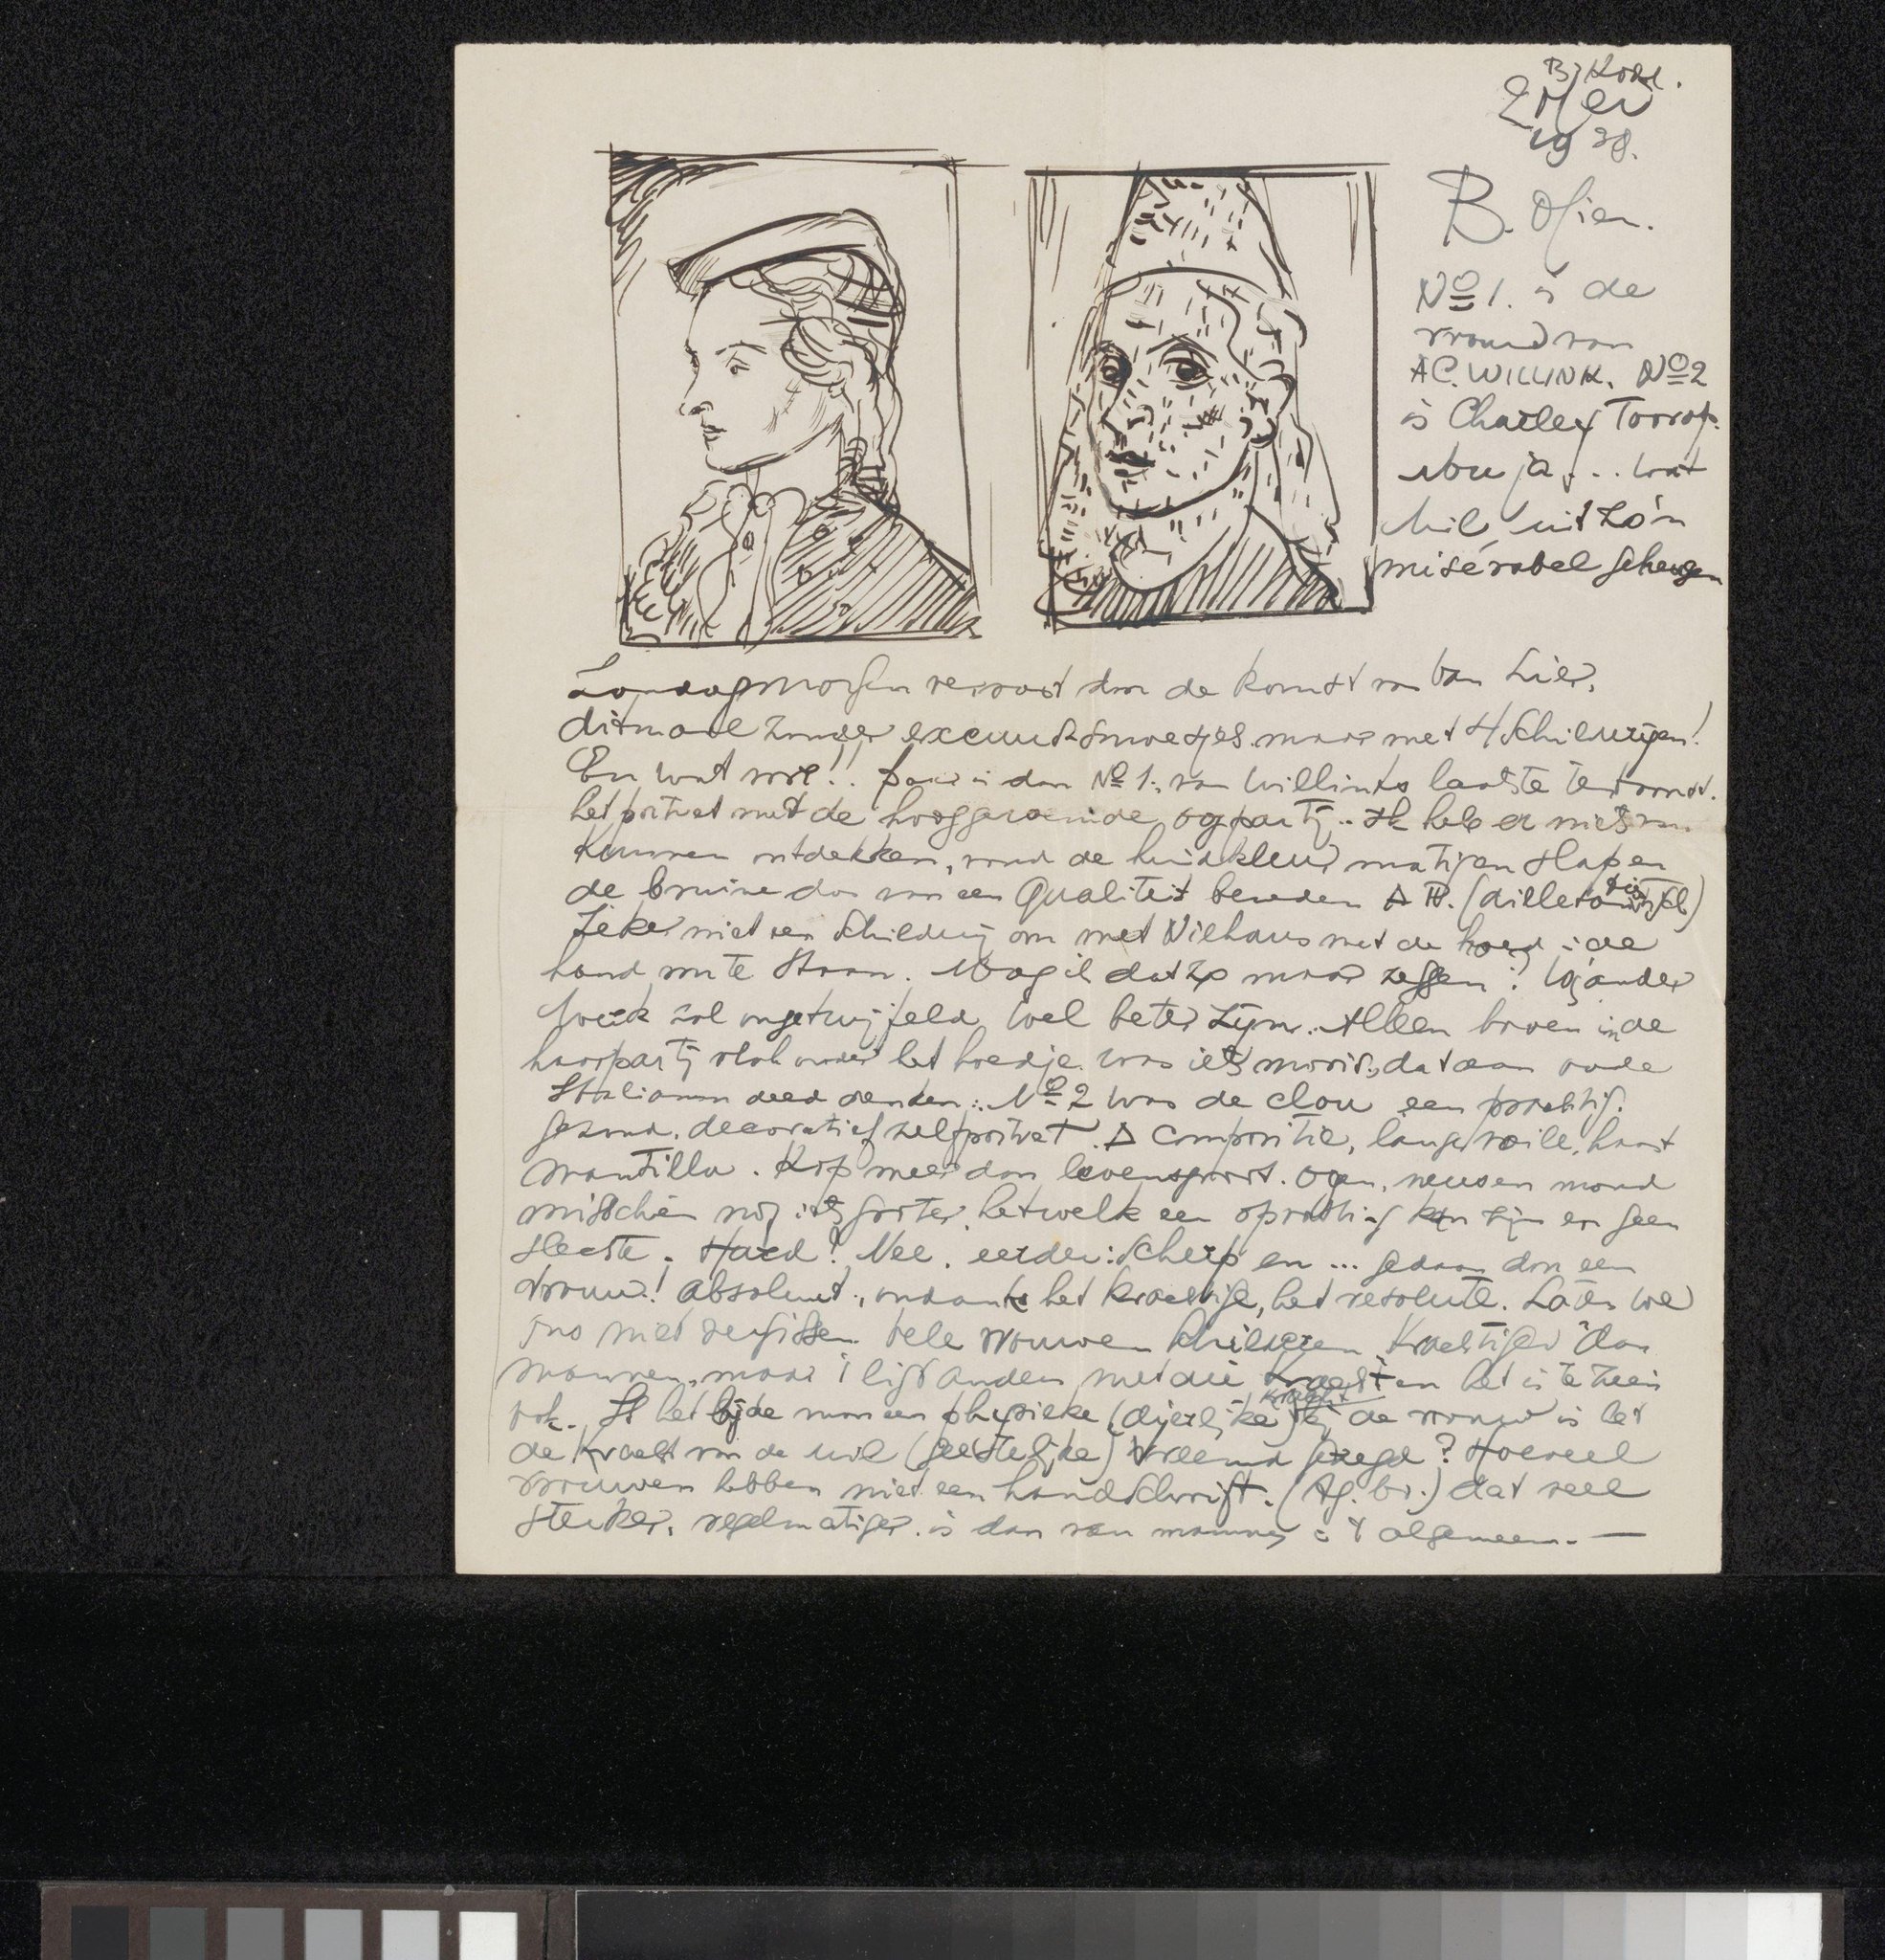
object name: letter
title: Brief aan Mien Cambier van Nooten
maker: dick ket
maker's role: draughtsman, print maker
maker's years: 1902-1940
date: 1938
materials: ink, paper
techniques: pen, writing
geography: bennekom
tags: the hague, mien cambier van nooten, charley toorop, amsterdam, print maker, draughtsman, carel willink, edgar fernhout, utrecht, nicolaas beets, haarlem, dollmaker, textile artist, nelly johanna hagelen-schilt, stamp (~ postal matter), travelling; tourism, painting (including book-illumination, miniature-painting), historical persons (portraits and scenes from the life)